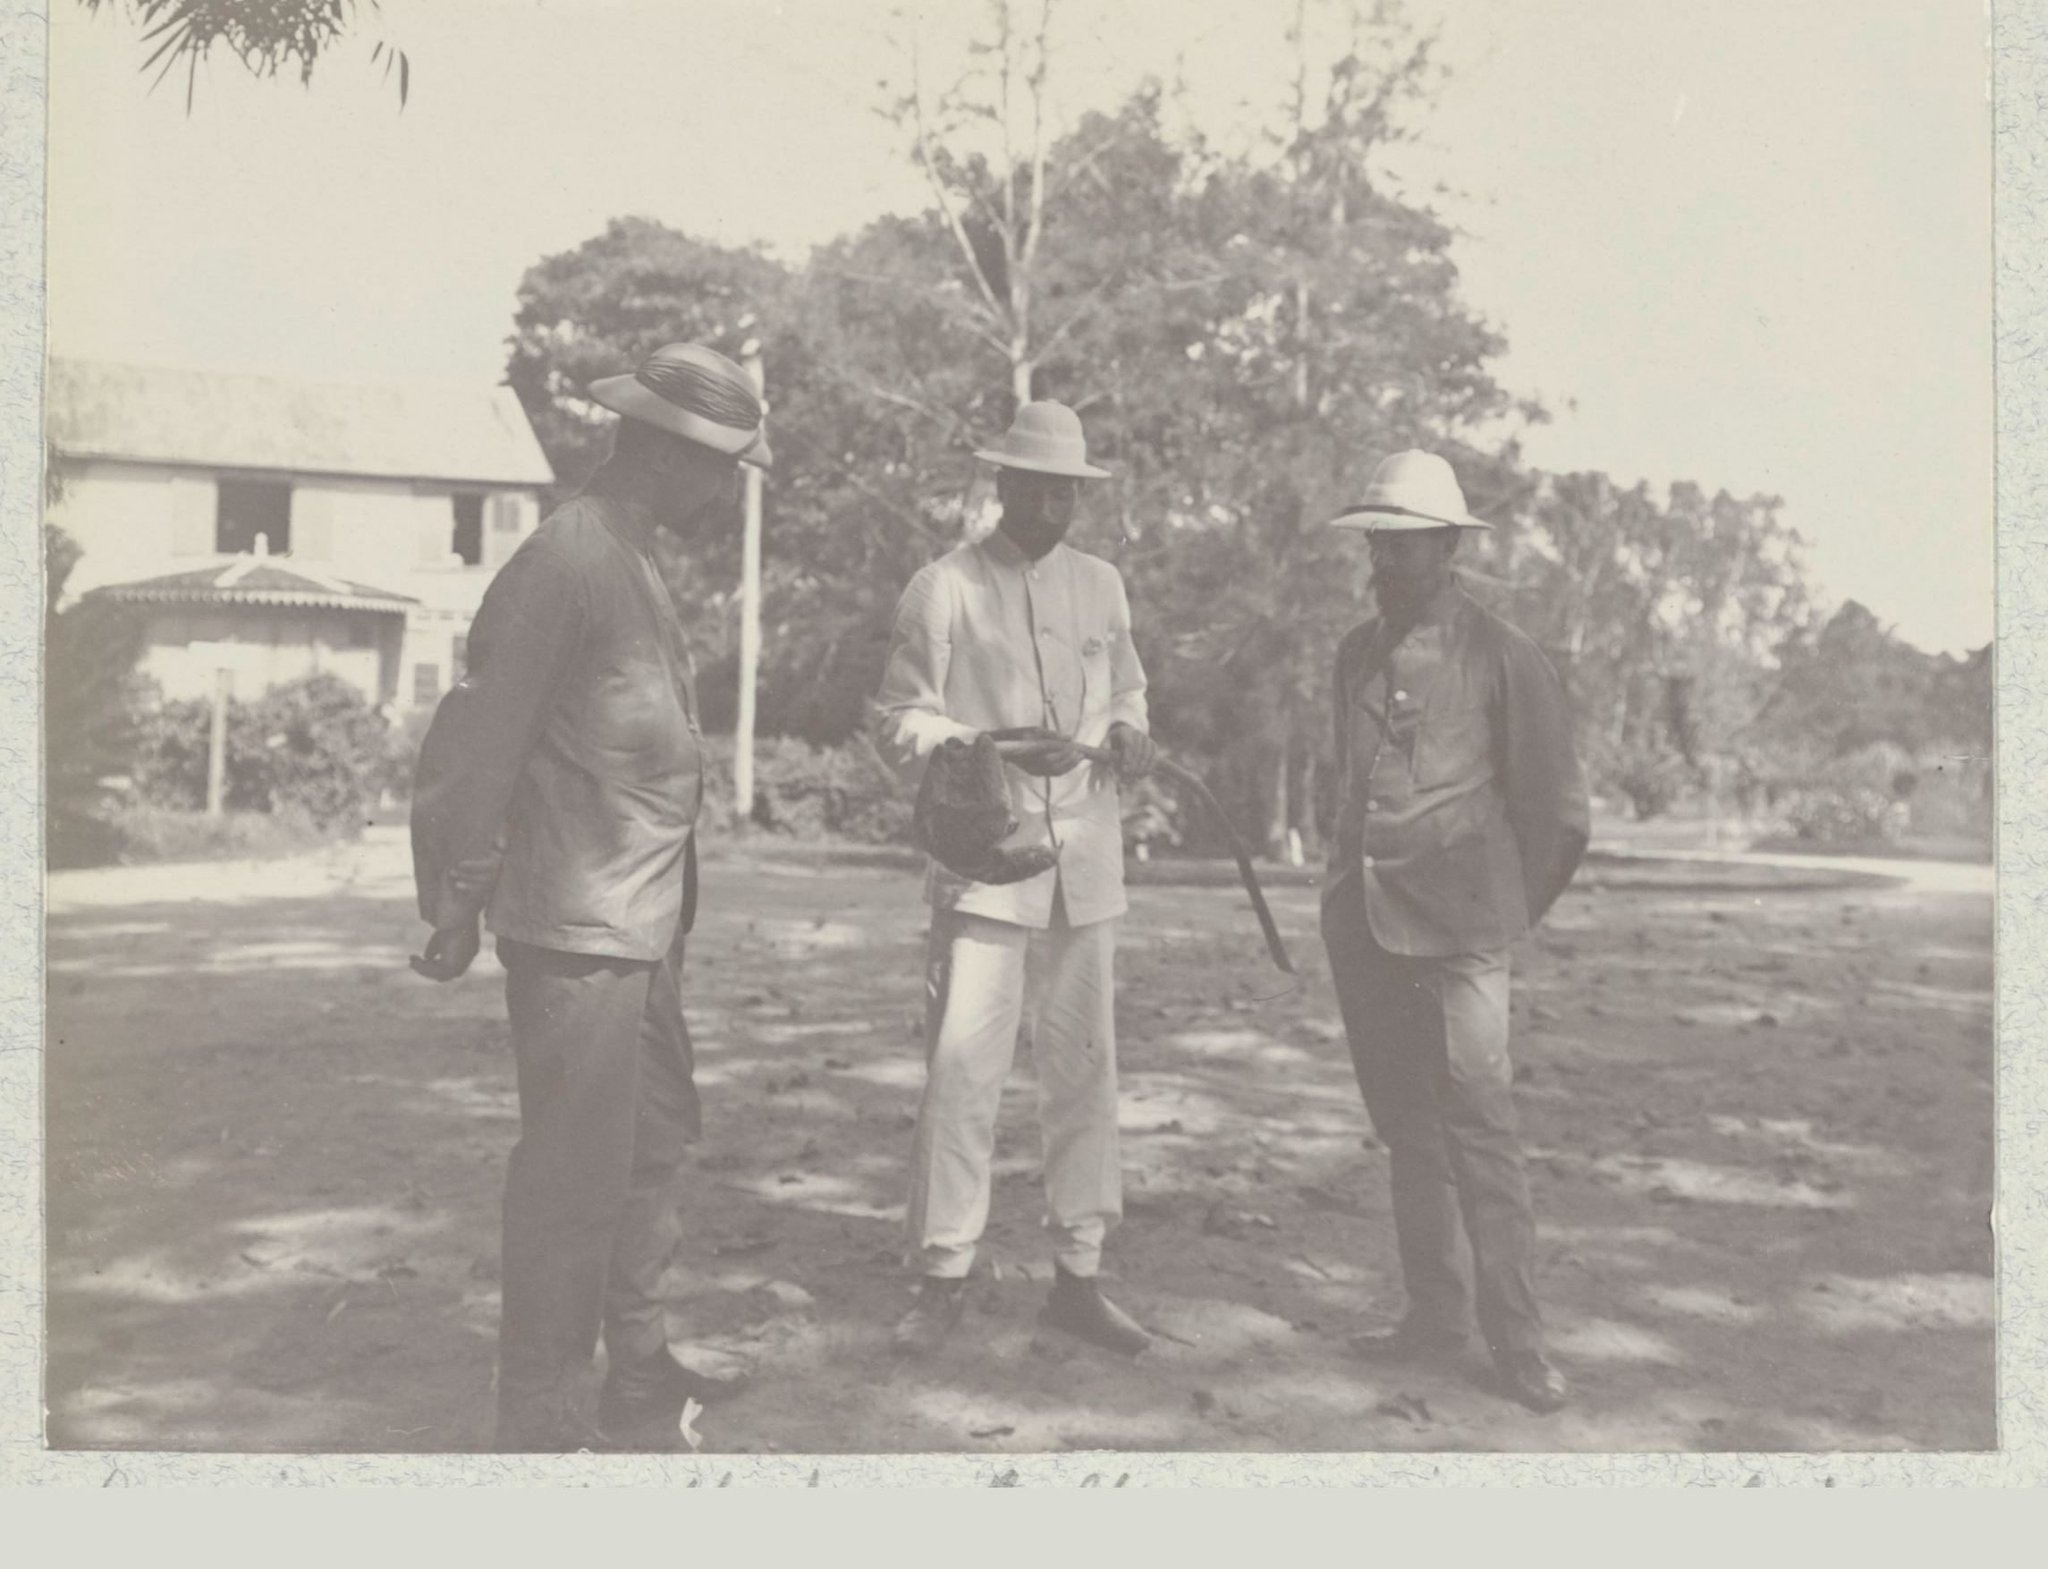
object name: photograph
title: Garnizoensapotheker Bolten met luiaard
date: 1908-1910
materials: photographic support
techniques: photography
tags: pharmacist, druggist, apothecary; pharmacy, drugstore, dispensing chemist, other mammals (with name)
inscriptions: inscription: ‘Garnizoensapotheker Bolten met 'n jonge luiaard’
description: Garnizoensapotheker Bolten met een jonge luiaard en twee mannen, Paramaribo, oktober 1908. Onderdeel van het fotoalbum van de familie Boom-Gonggrijp in Suriname en Curaçao.